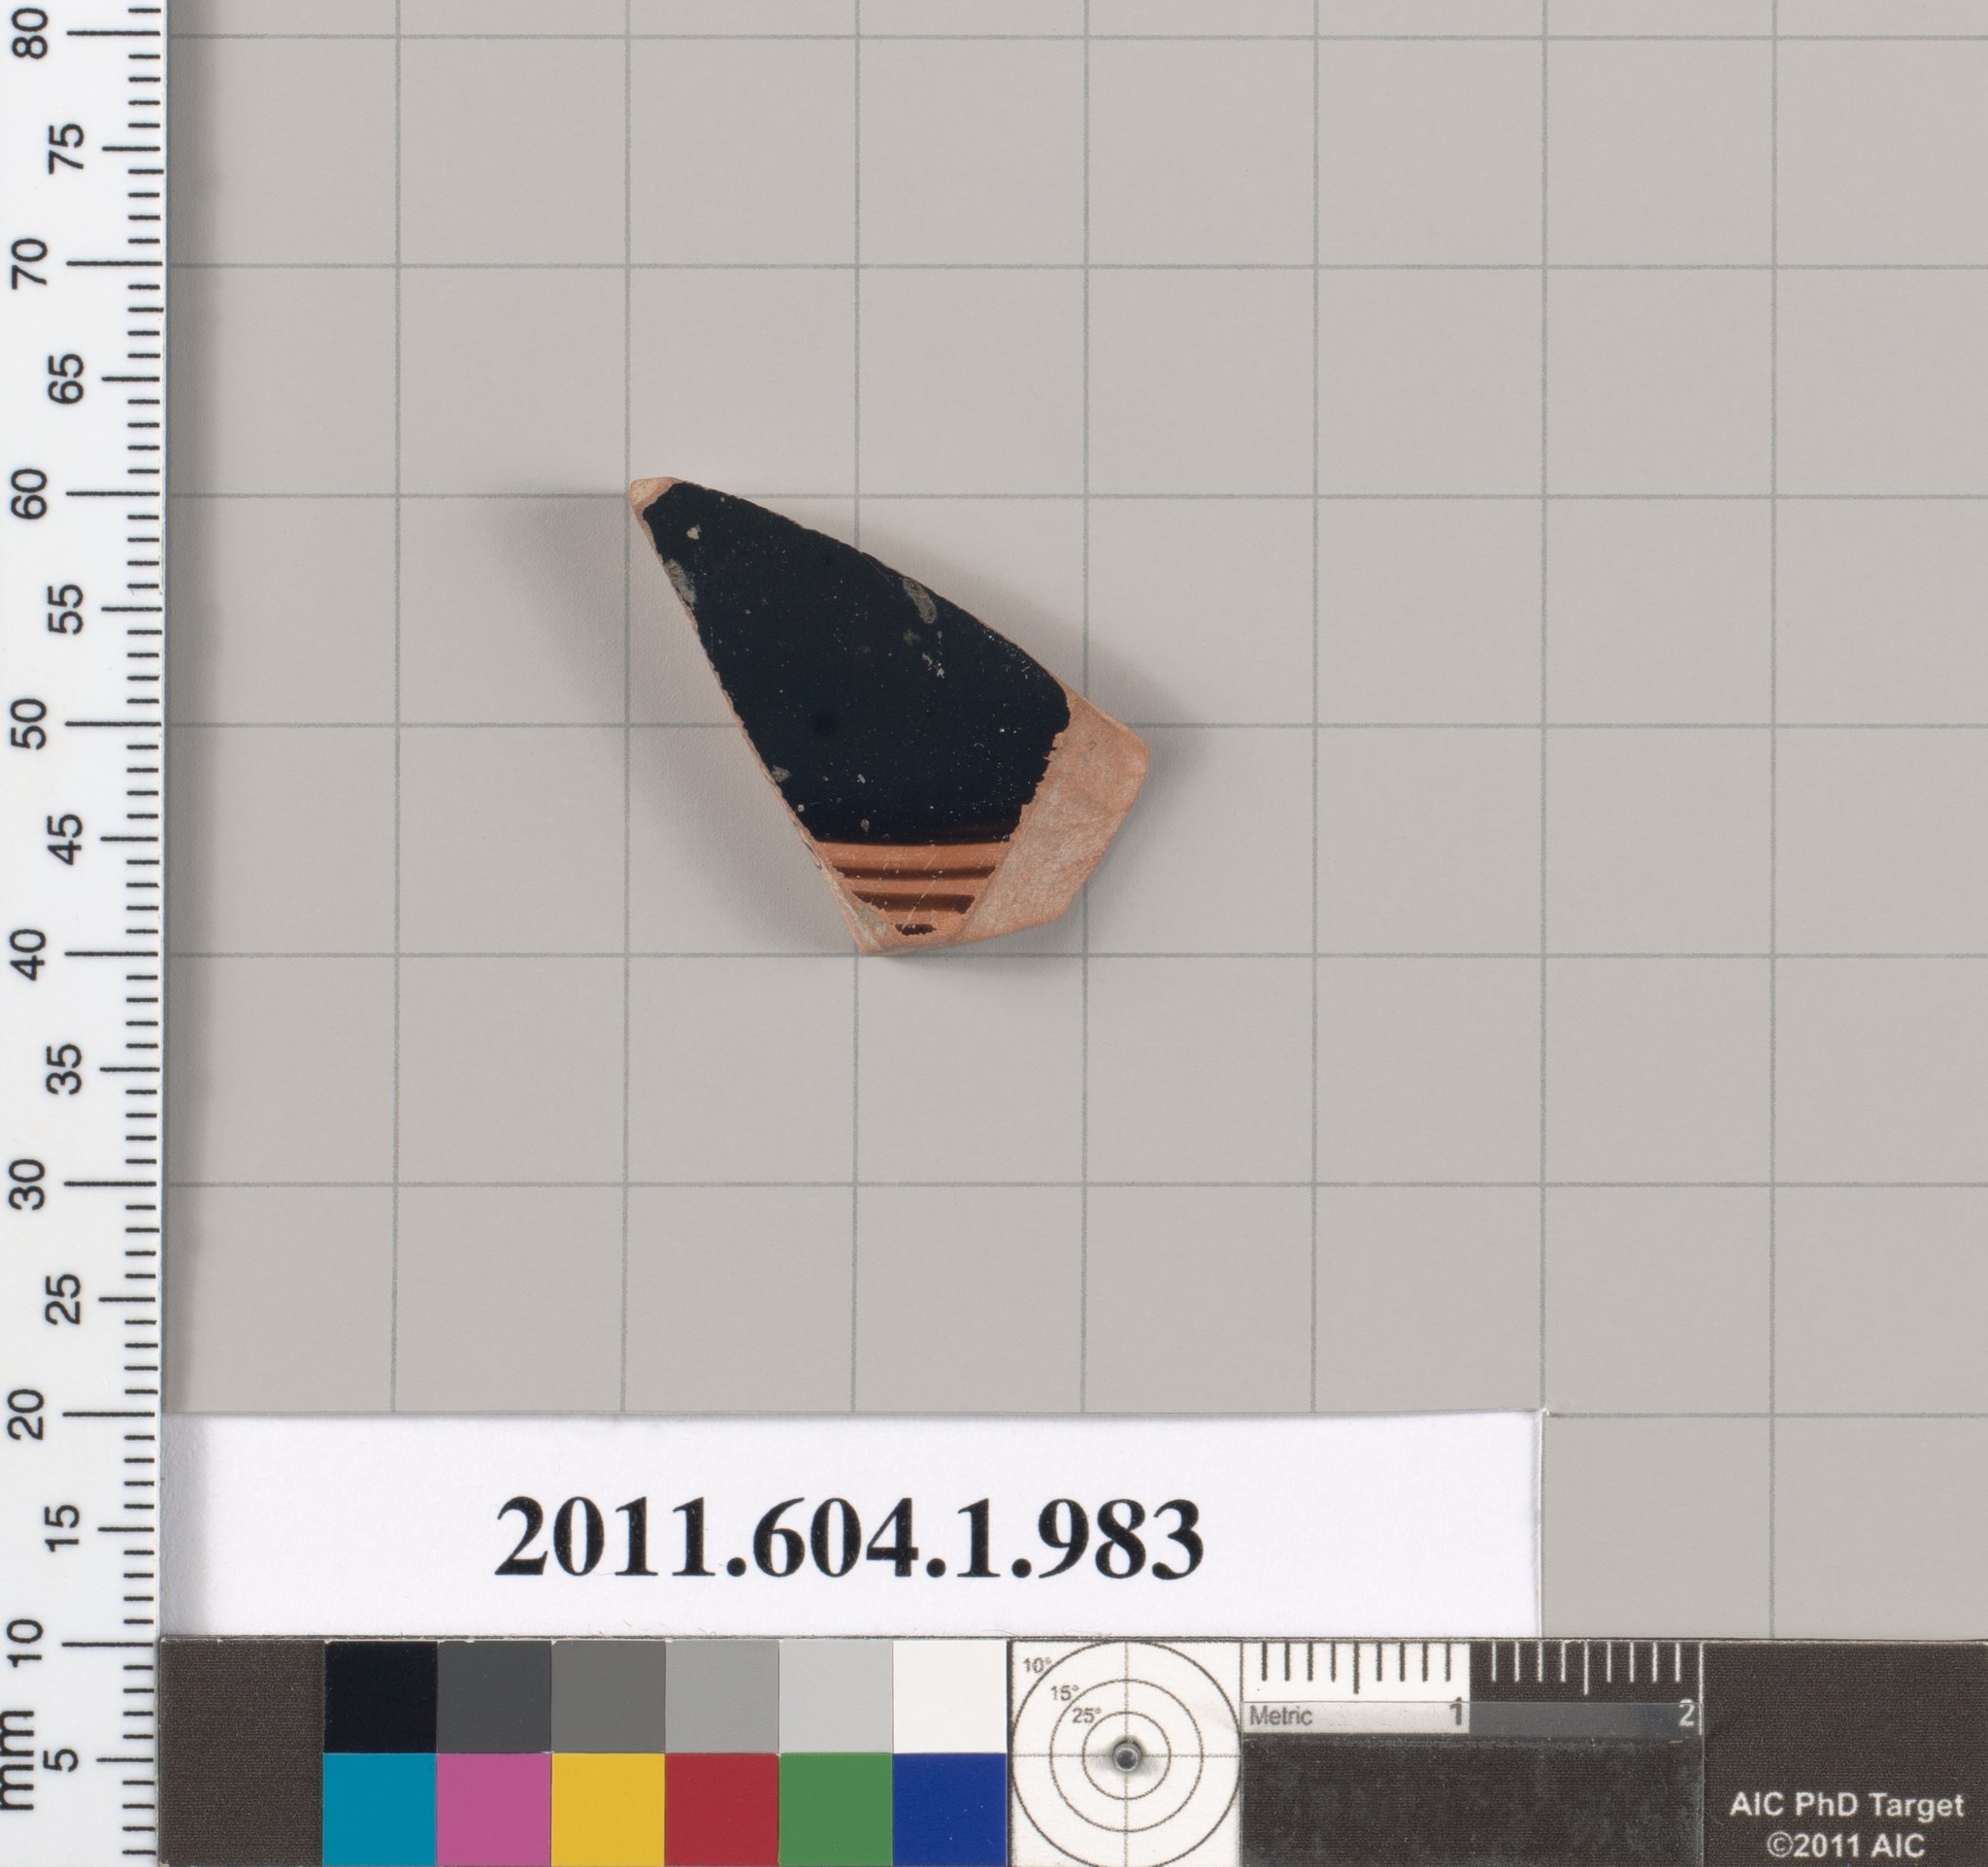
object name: kylix fragment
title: Terracotta fragment of a kylix (drinking cup)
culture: greek, attic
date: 490-480 BCE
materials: terracotta